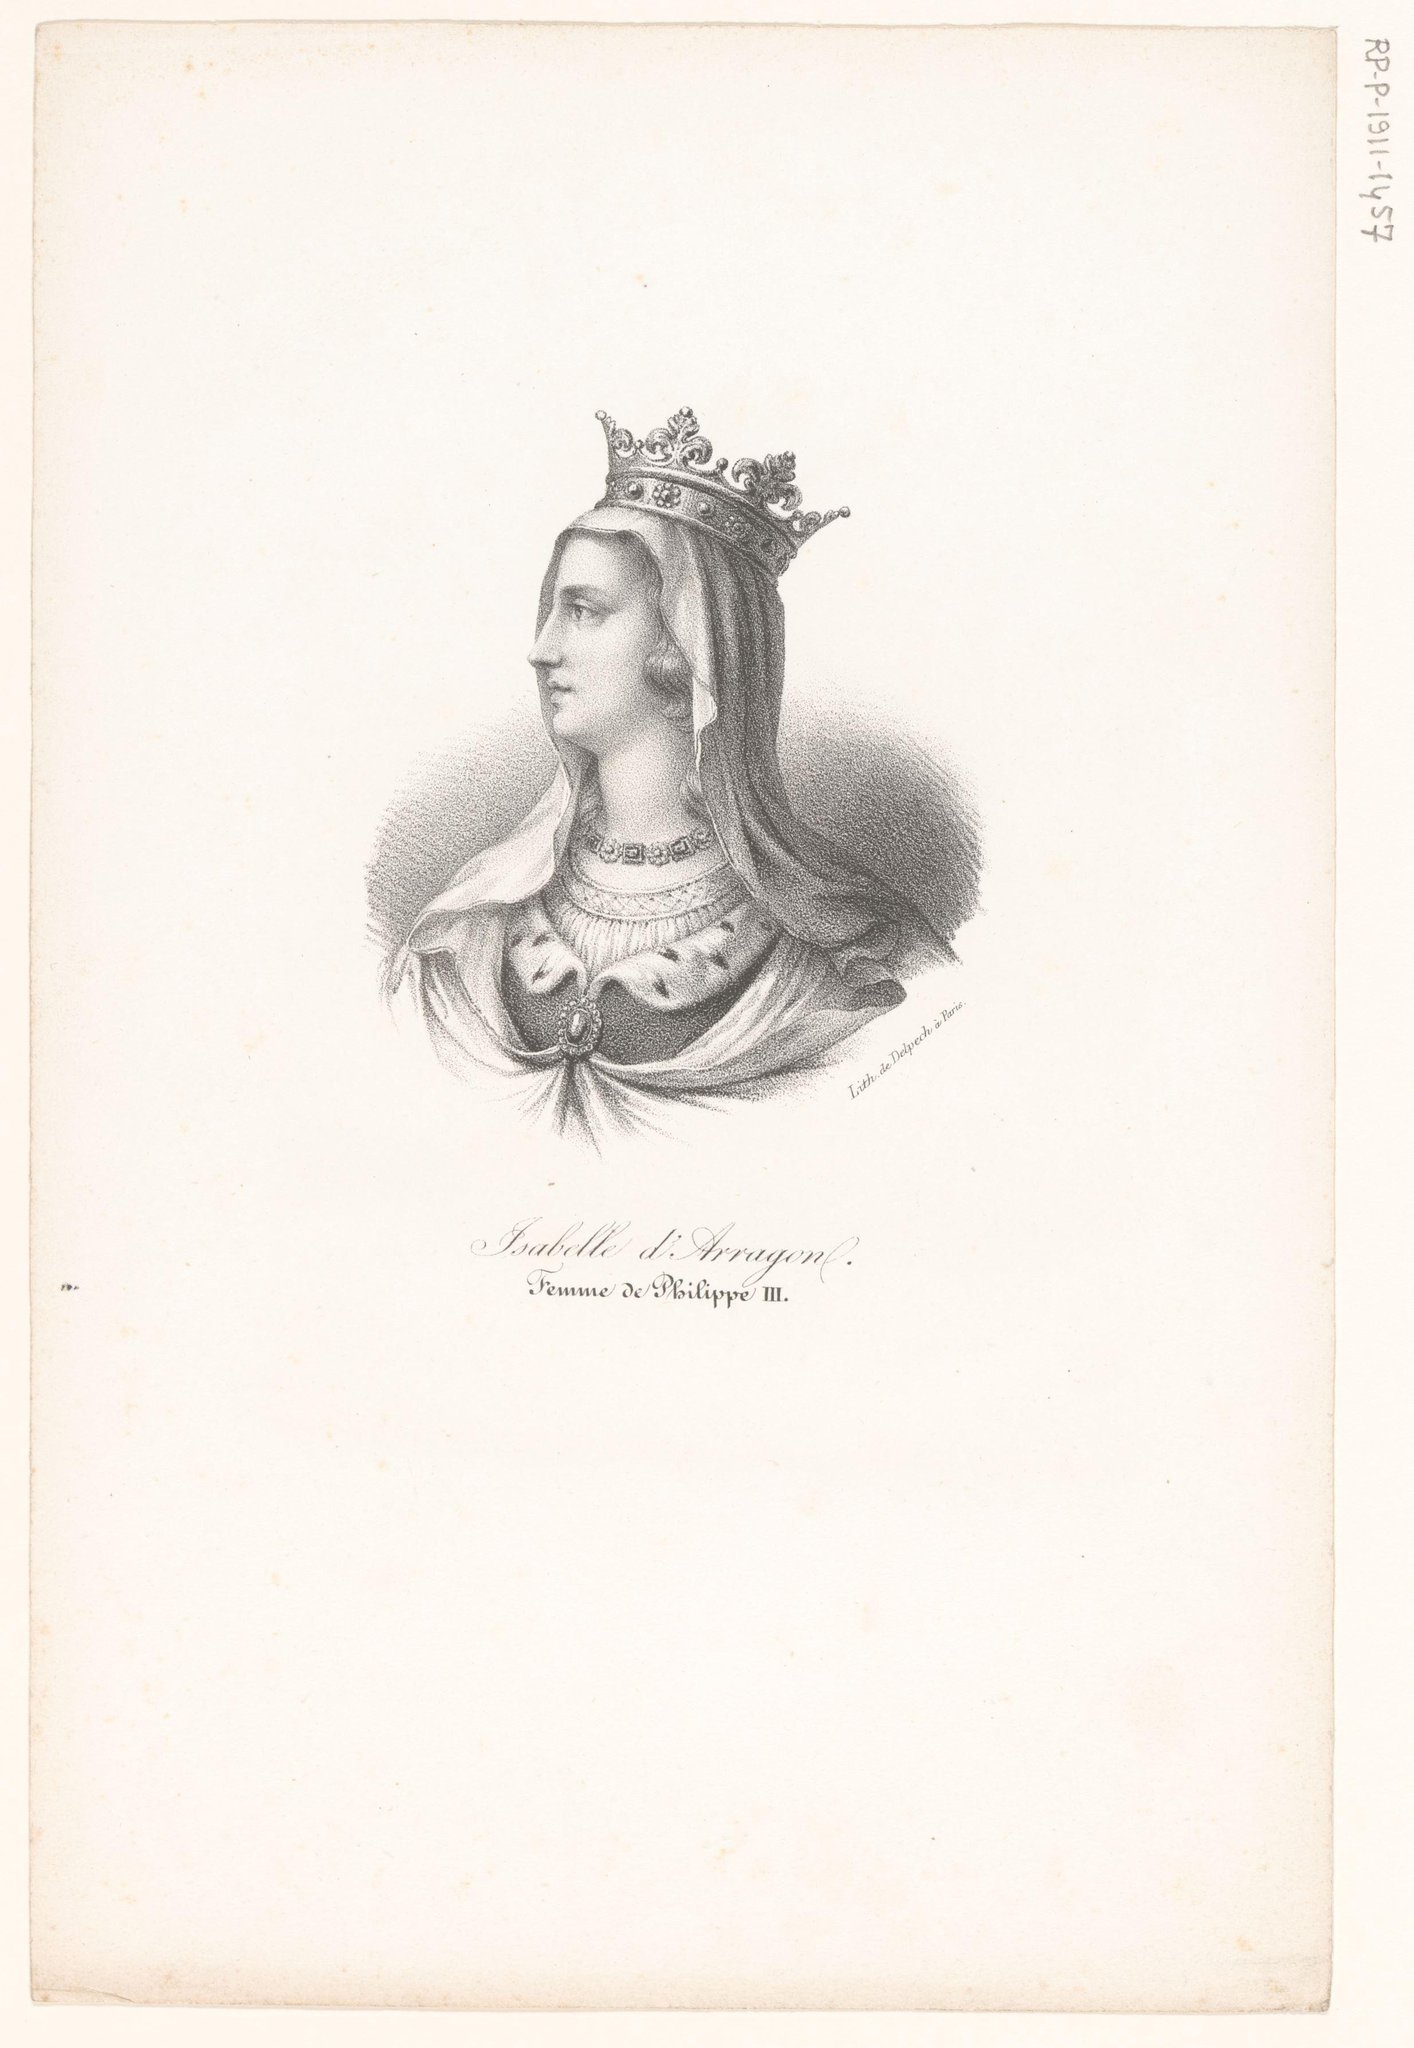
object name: print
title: Isabelle d'Arragon, femme de Philippe III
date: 1818-1842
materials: paper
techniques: lithograph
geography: paris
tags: historical persons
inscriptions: collector's mark: Lugt 2228a